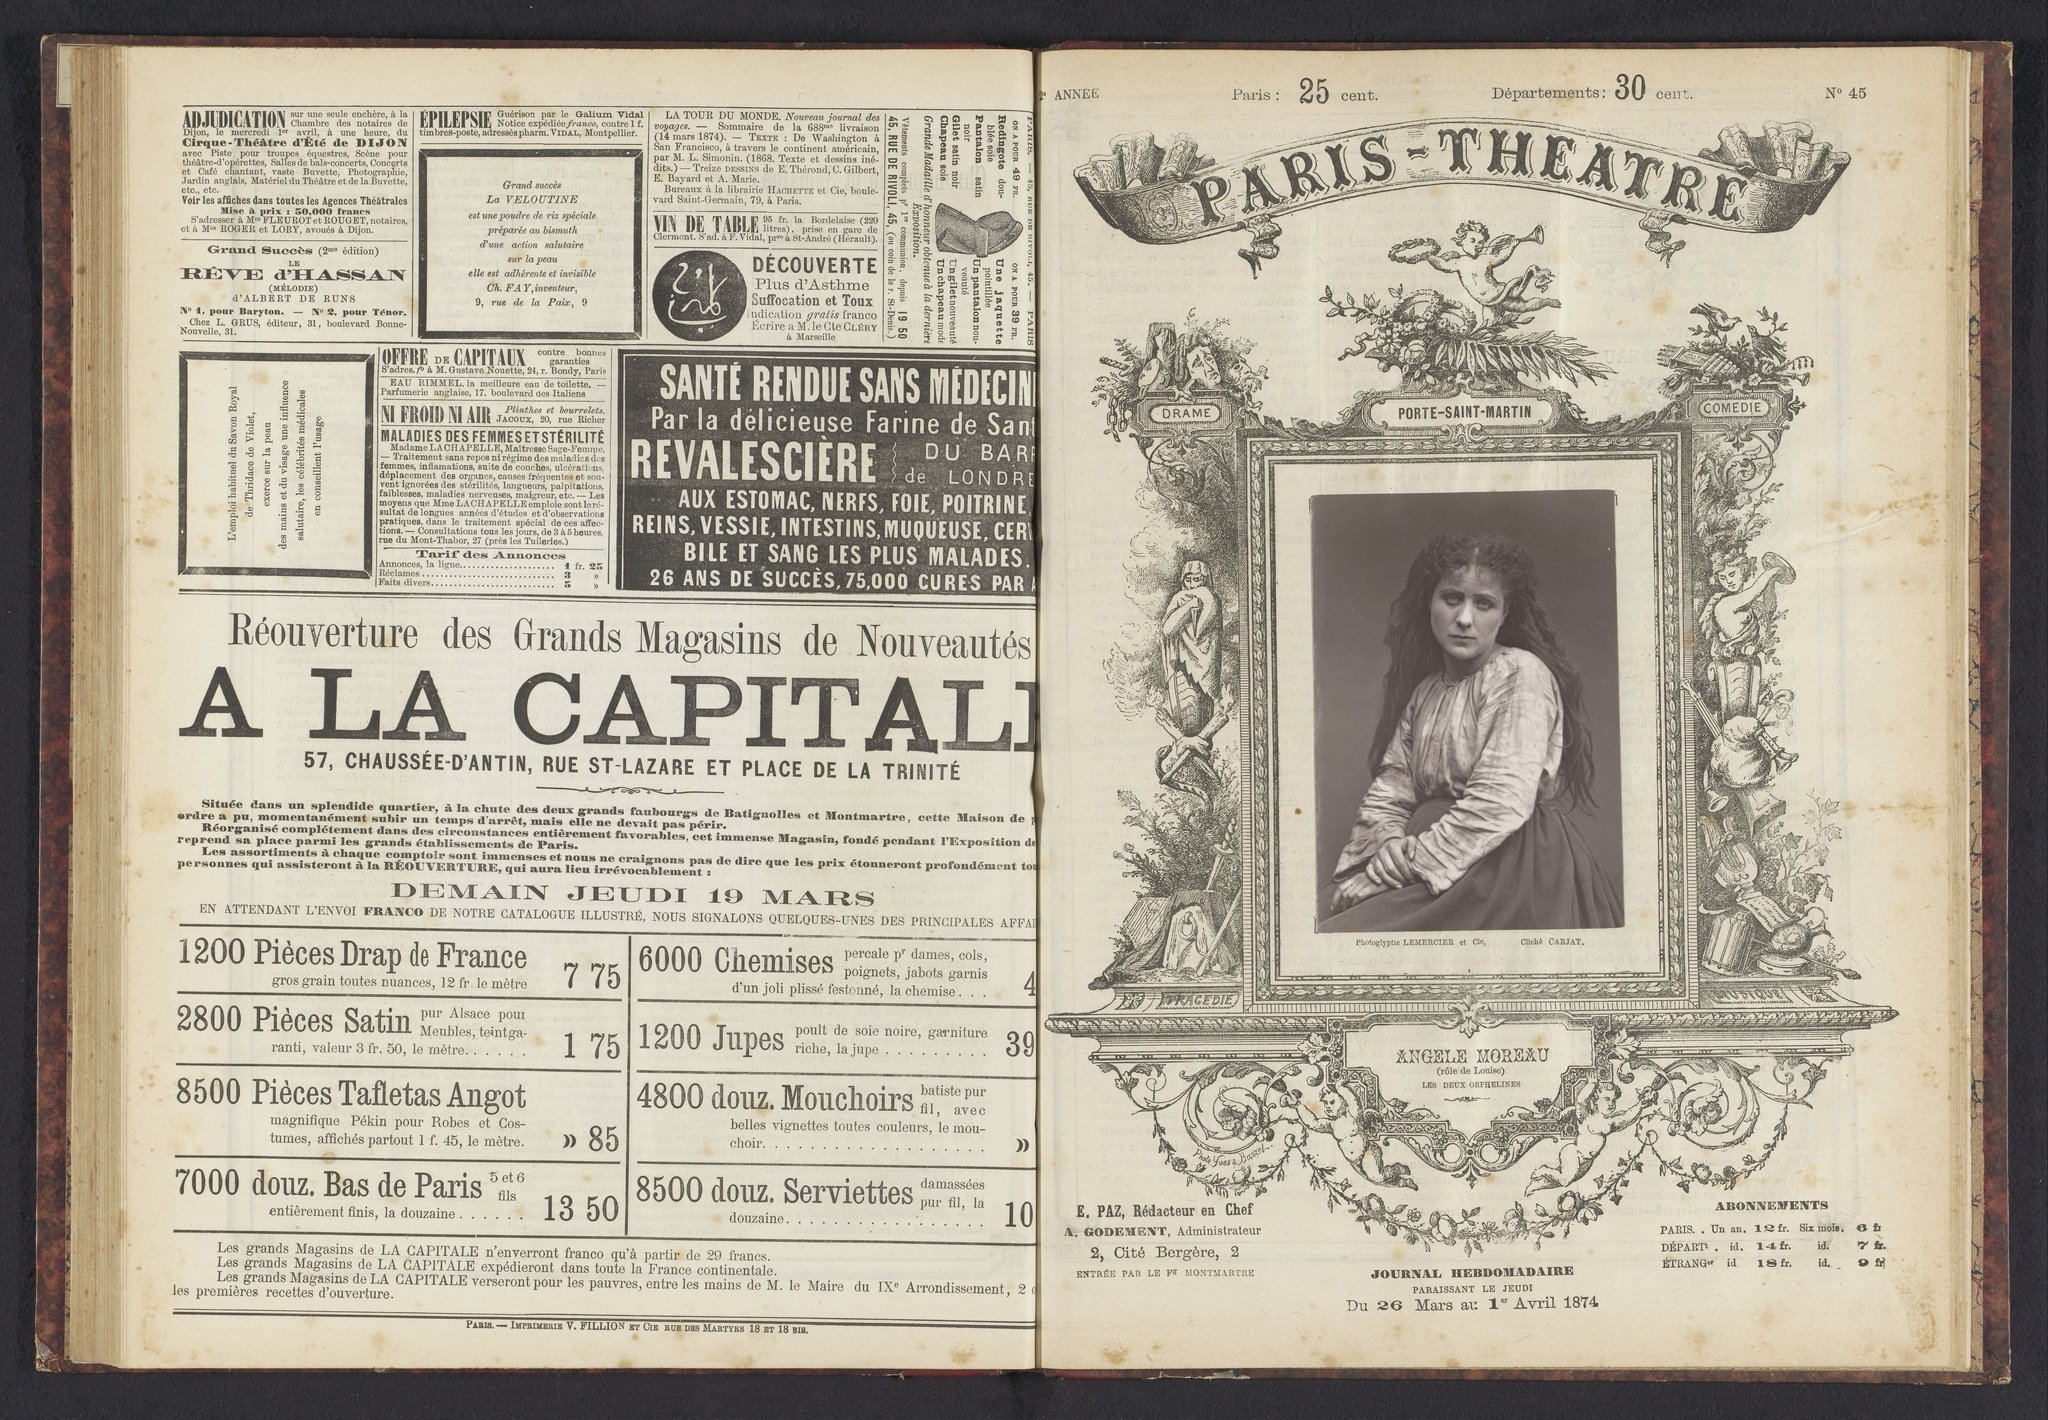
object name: page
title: Portret van Angele Moreau als Louise in Les Deux Orphelines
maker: étienne carjat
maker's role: draughtsman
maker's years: 1828-1906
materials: paper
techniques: woodburytype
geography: france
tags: portrait of actor, actress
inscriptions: number: ‘No 45.’, inscription: ‘Journal hebdomadaire paraissant le Jeudi Du 26 Mars au 1er Avril 1874’